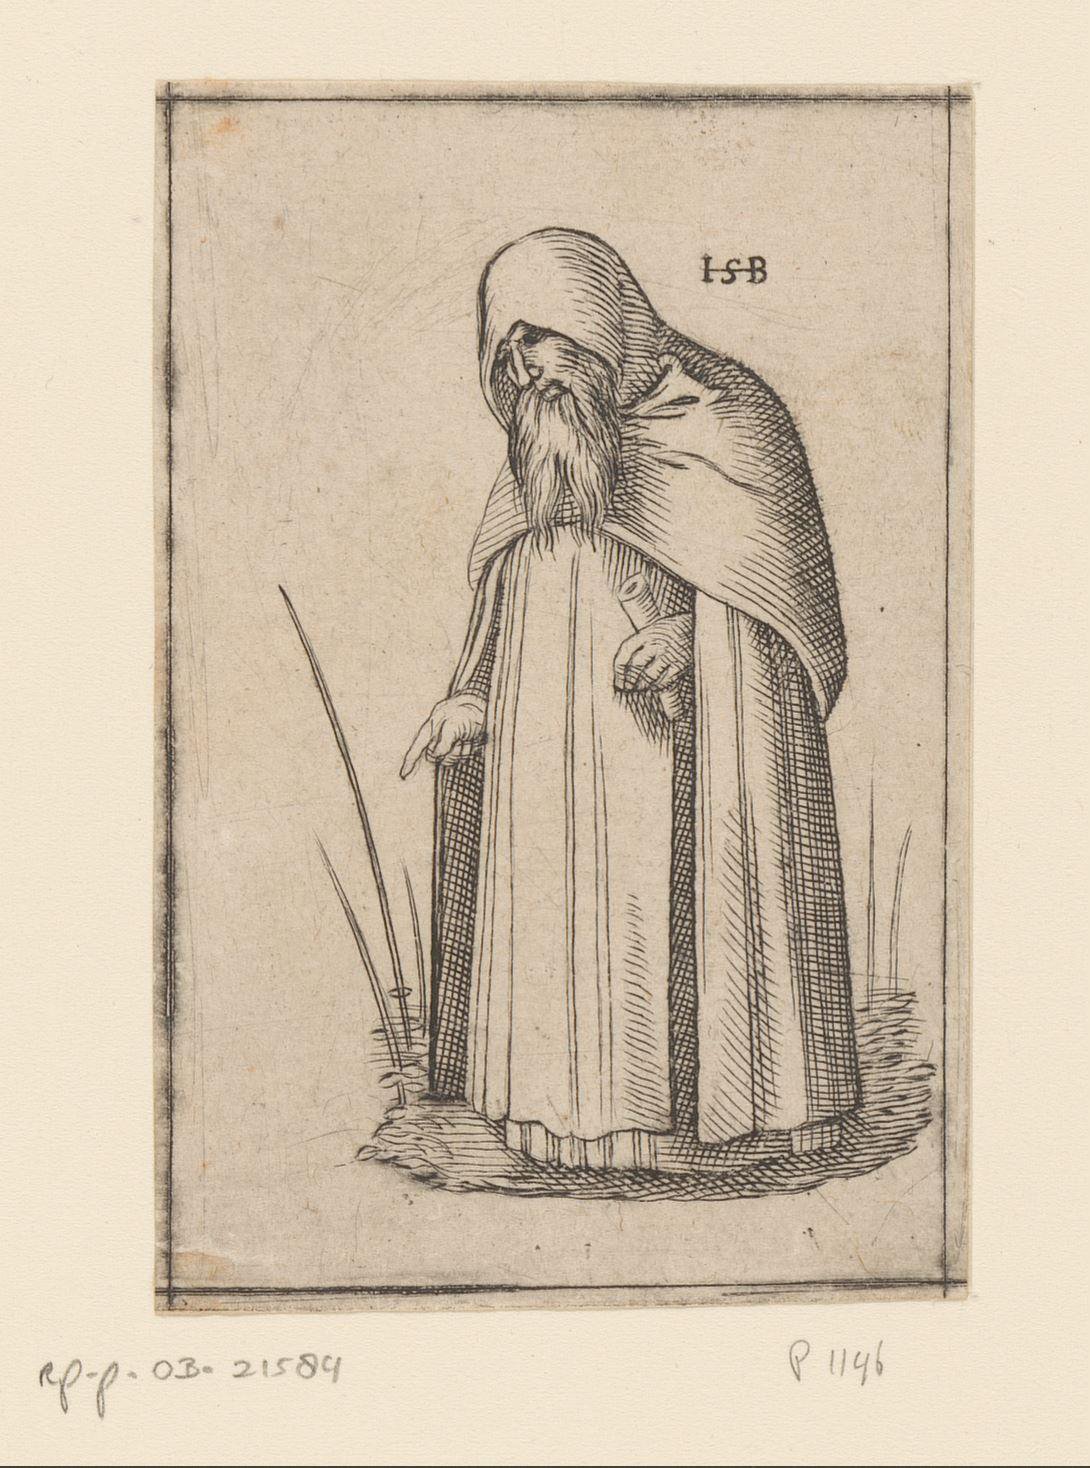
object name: print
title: Monnik van de orde der Tempelieren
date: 1526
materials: paper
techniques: engraving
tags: liturgical vestments, canonicals, monastic orders, monastic life ~ roman catholic church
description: Onderdeel van een serie van 28 gegraveerde kopieën in de andere richting naar Hans Sebald Behams "Das Papstthum mit seinen Gliedern", 1526.